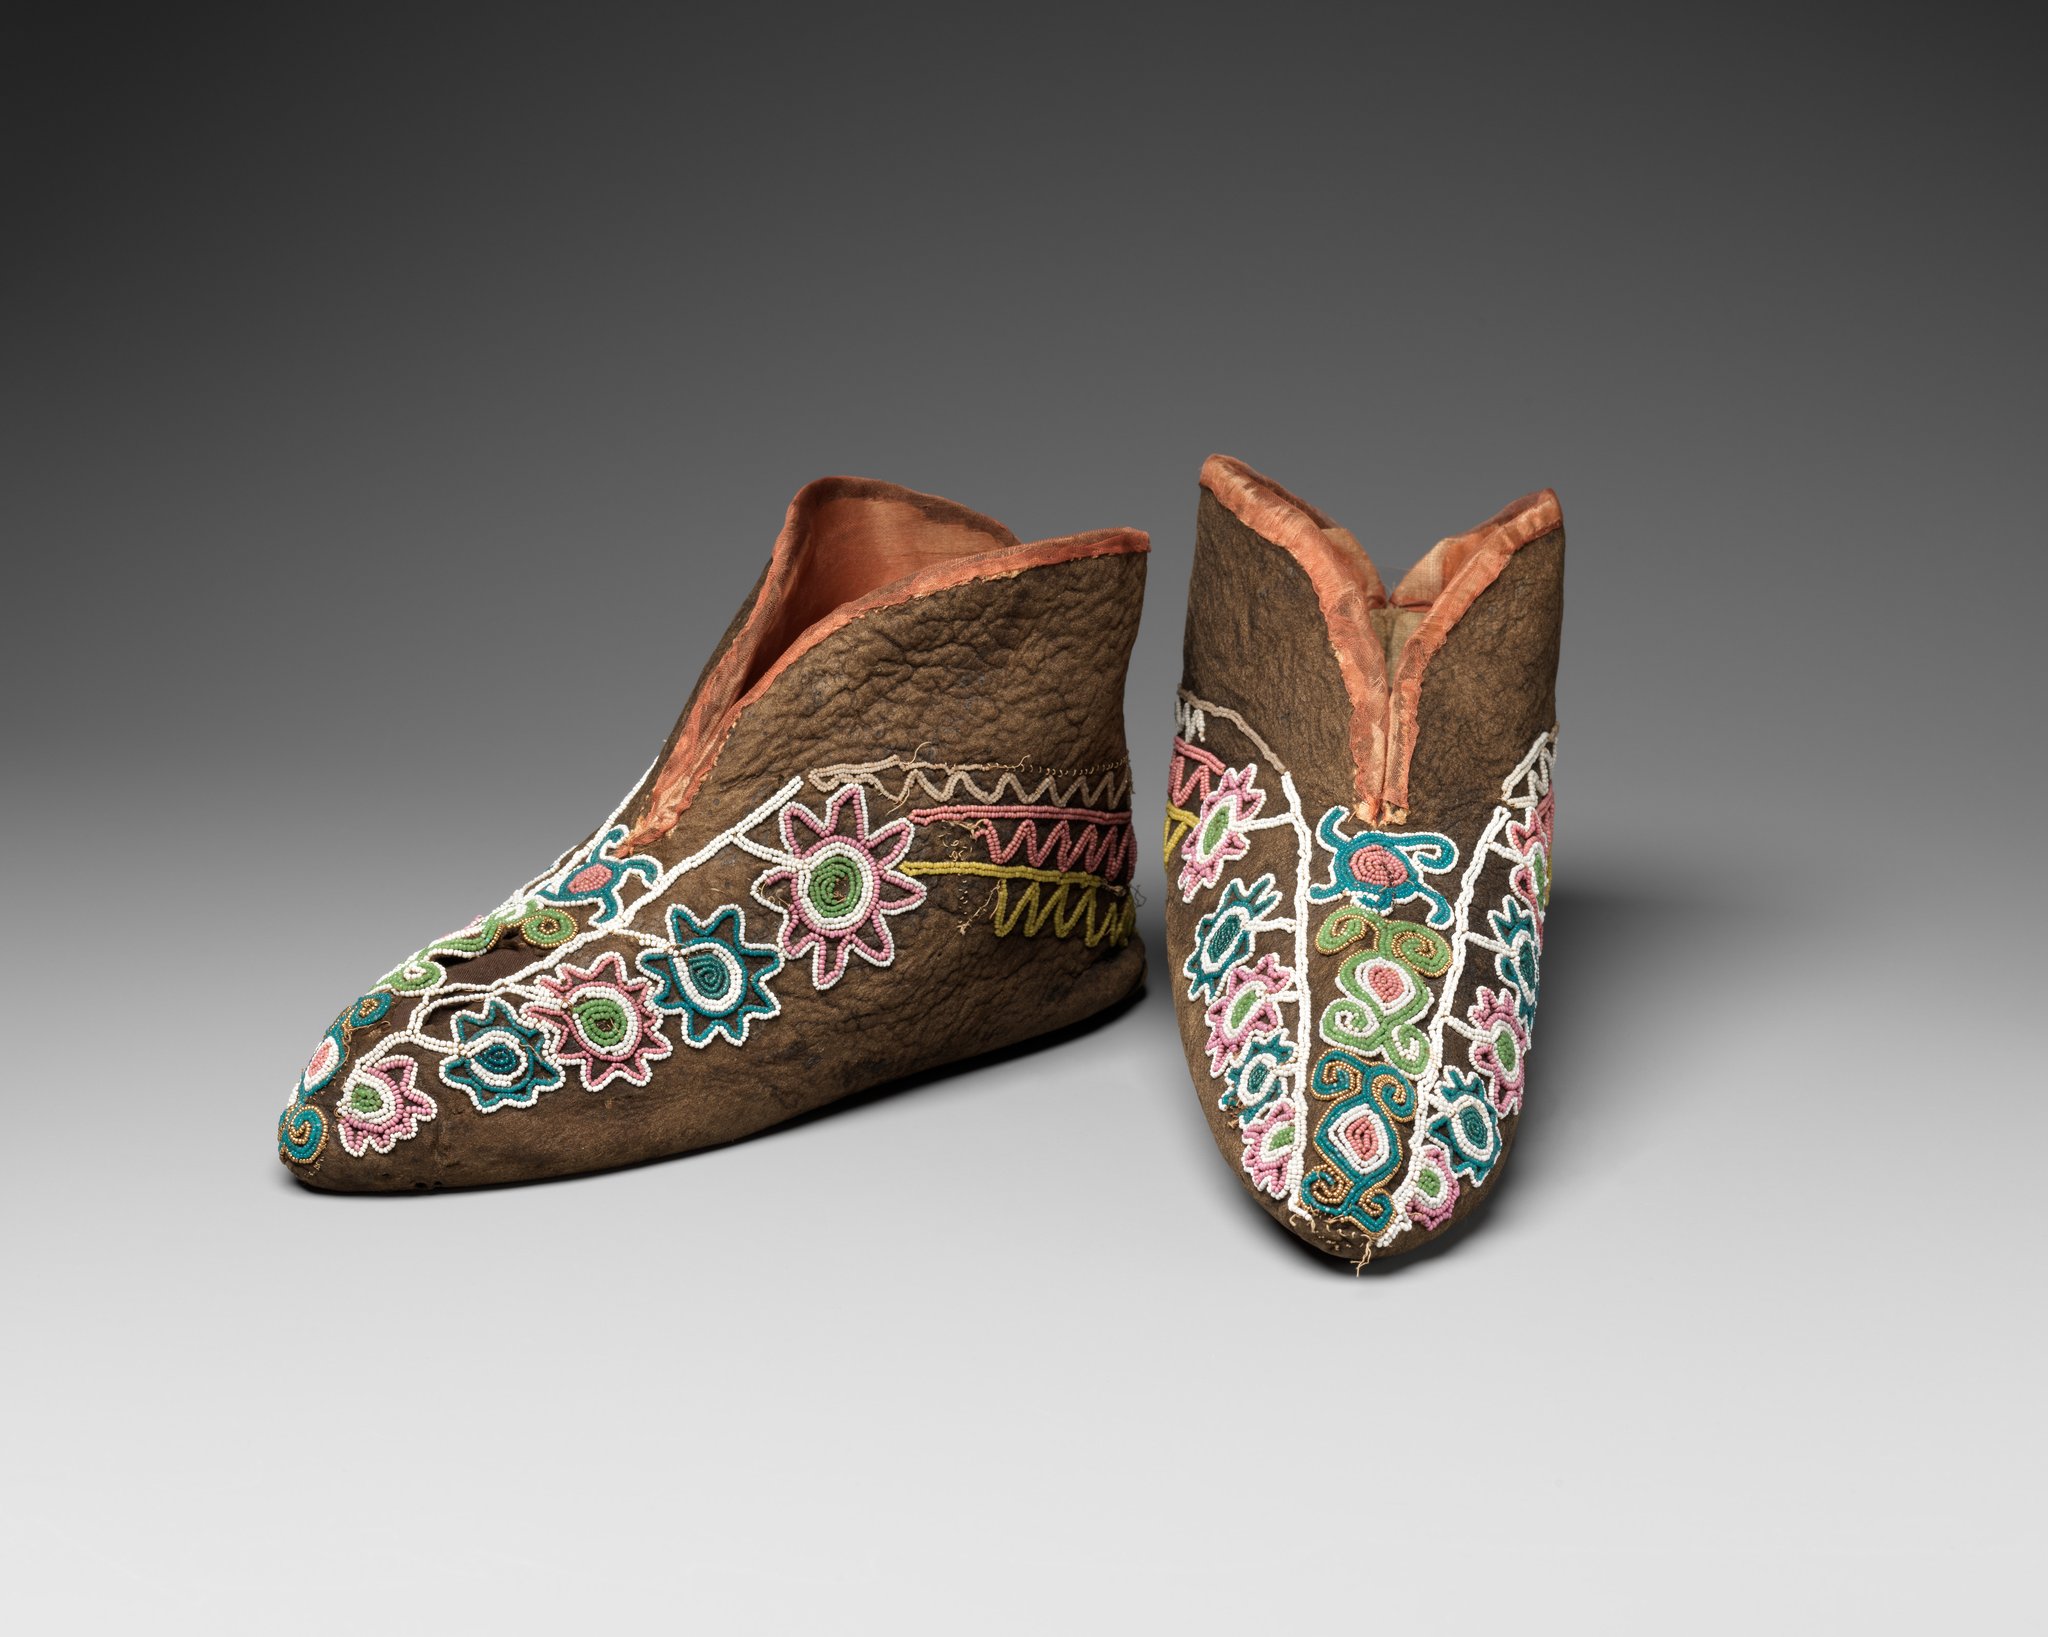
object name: moccasin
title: Moccasins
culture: muscogee or creek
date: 1830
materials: textile, cotton, dye, glass, leather, metal, ribbon, silk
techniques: tanning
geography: united states